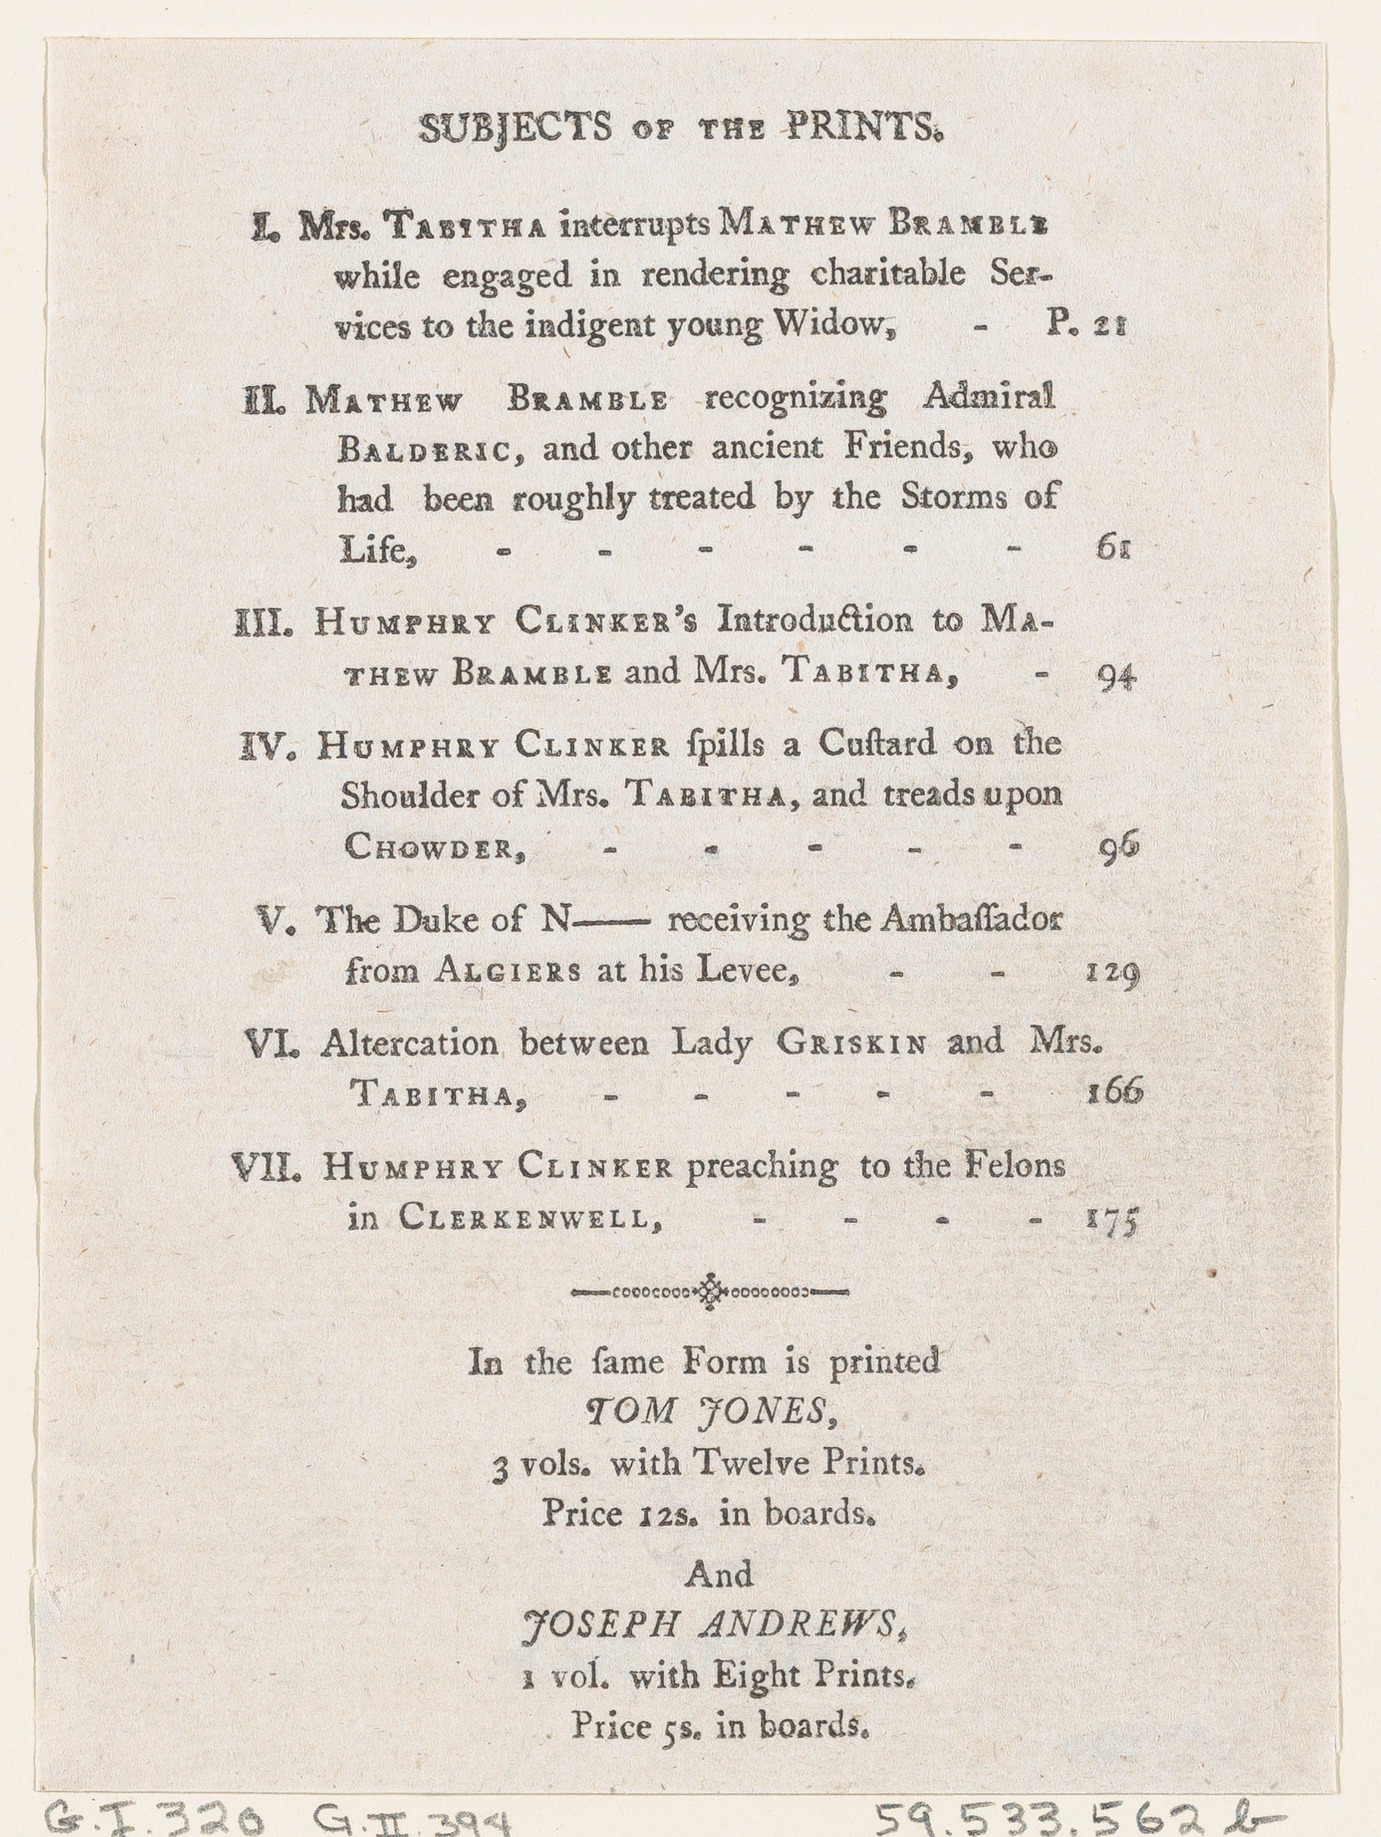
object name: print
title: List of Plates I-VII, from Tobias Smollett's "The Expedition of Humphry Clinker" (London, 1793), Vol. 1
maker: thomas rowlandson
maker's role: artist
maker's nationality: british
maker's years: 1757-1827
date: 1793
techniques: engraving